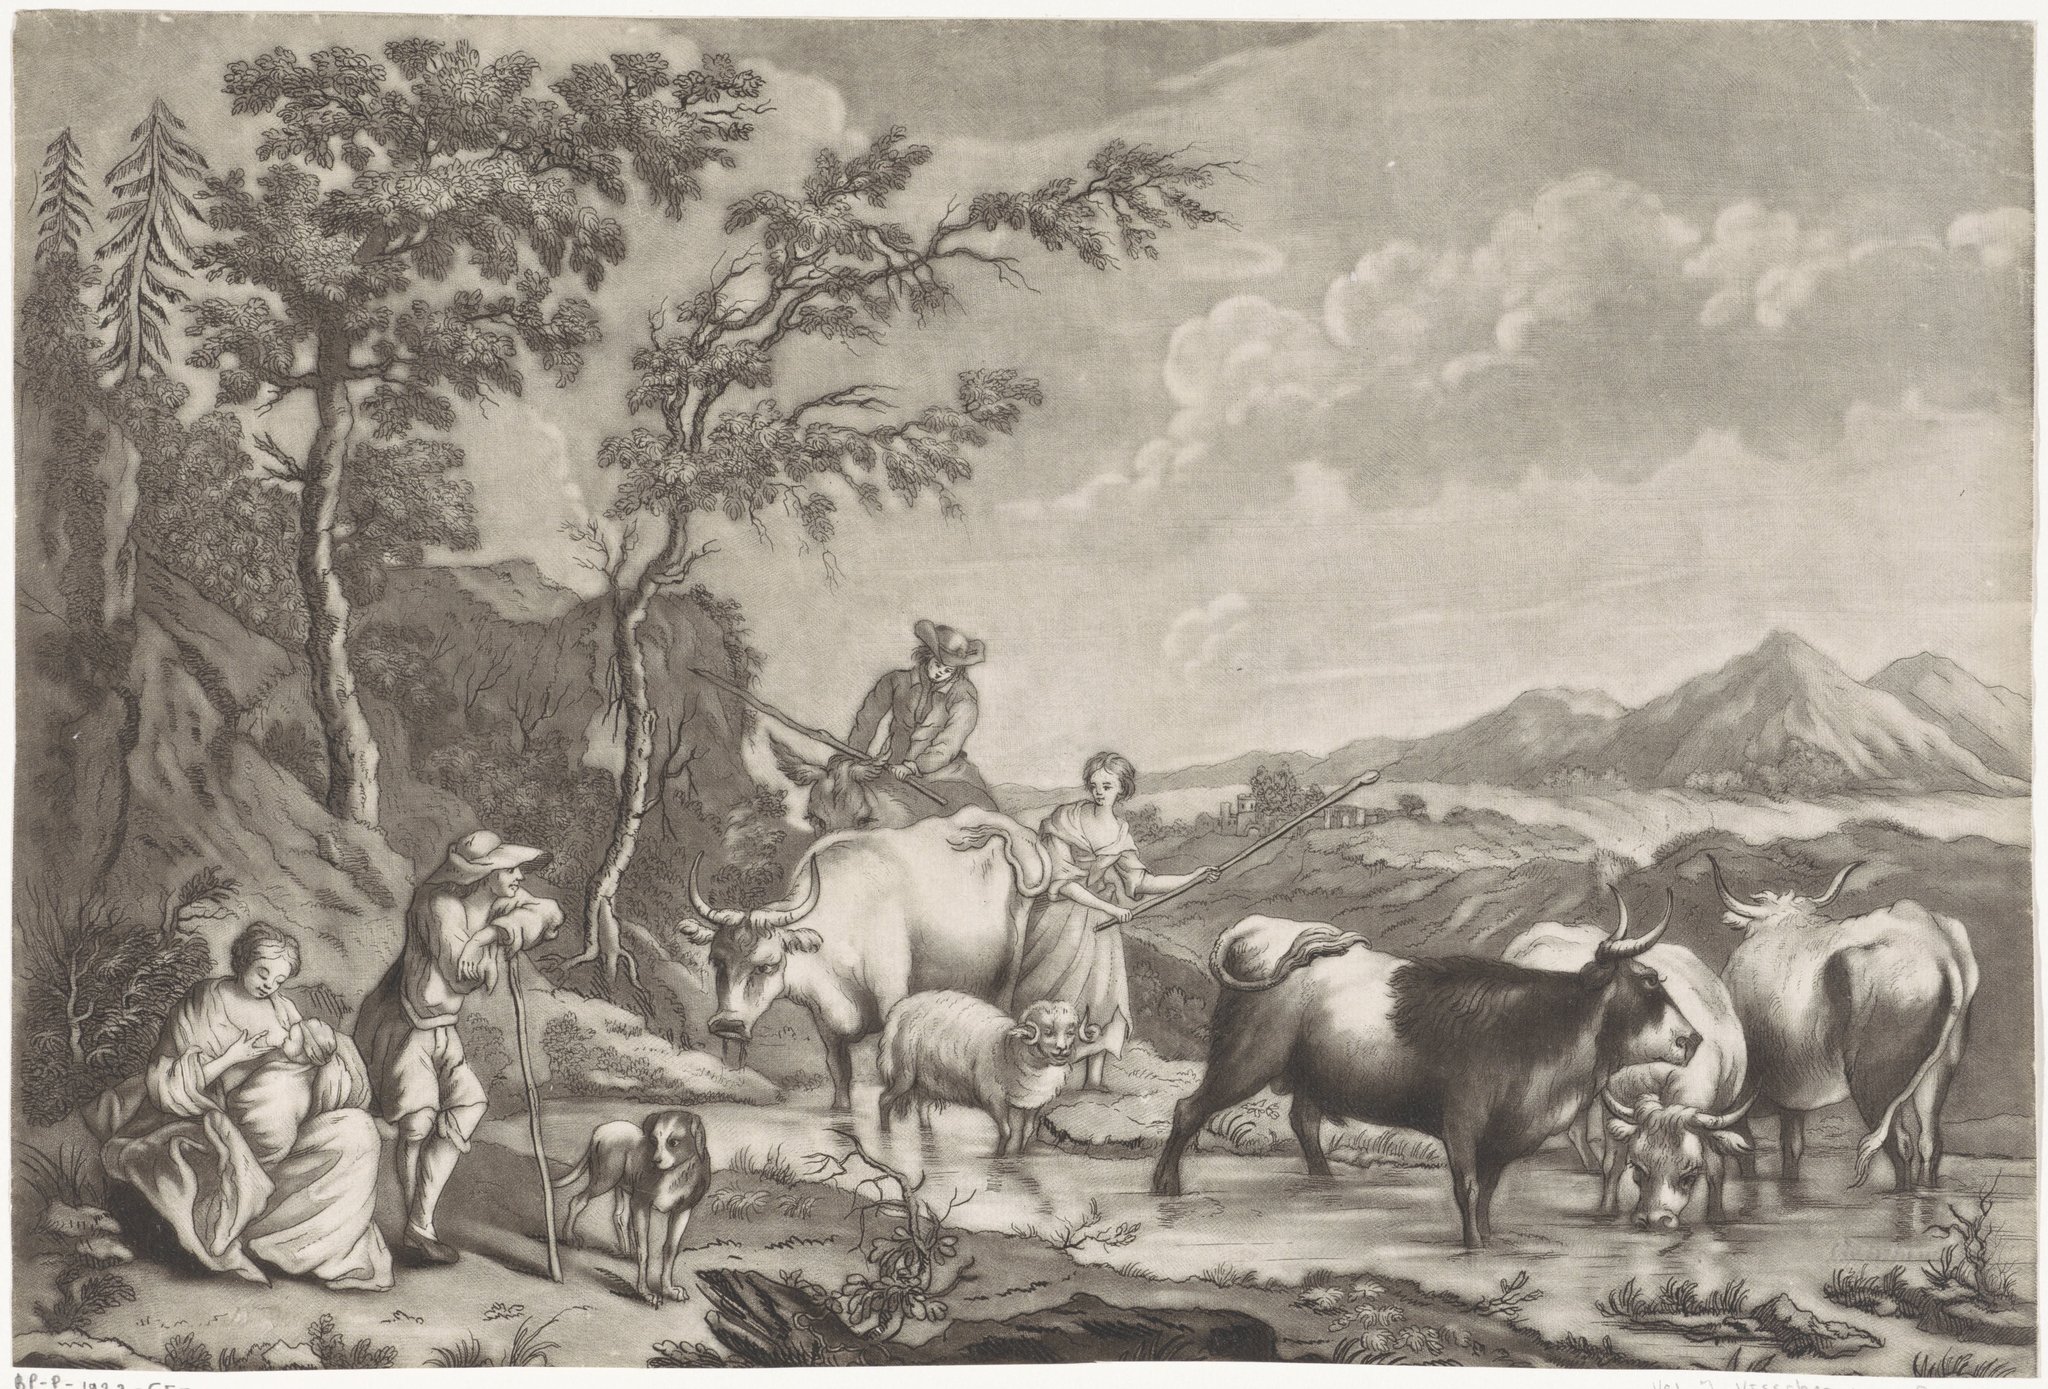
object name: print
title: Landschap met herders en vee bij een rivier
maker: Anonymous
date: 1650-1800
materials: paper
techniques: etching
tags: river, herding, herdsman, herdswoman, shepherd, shepherdess, cowherd, etc., herd, flock, dog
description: In een heuvelachtig landschap drijven een herder en een herderin hun vee door het water. Aan de waterrand leunt een herder op zijn stok en geeft een vrouw borstvoeding aan haar kind. Op de achtergrond een dorp.